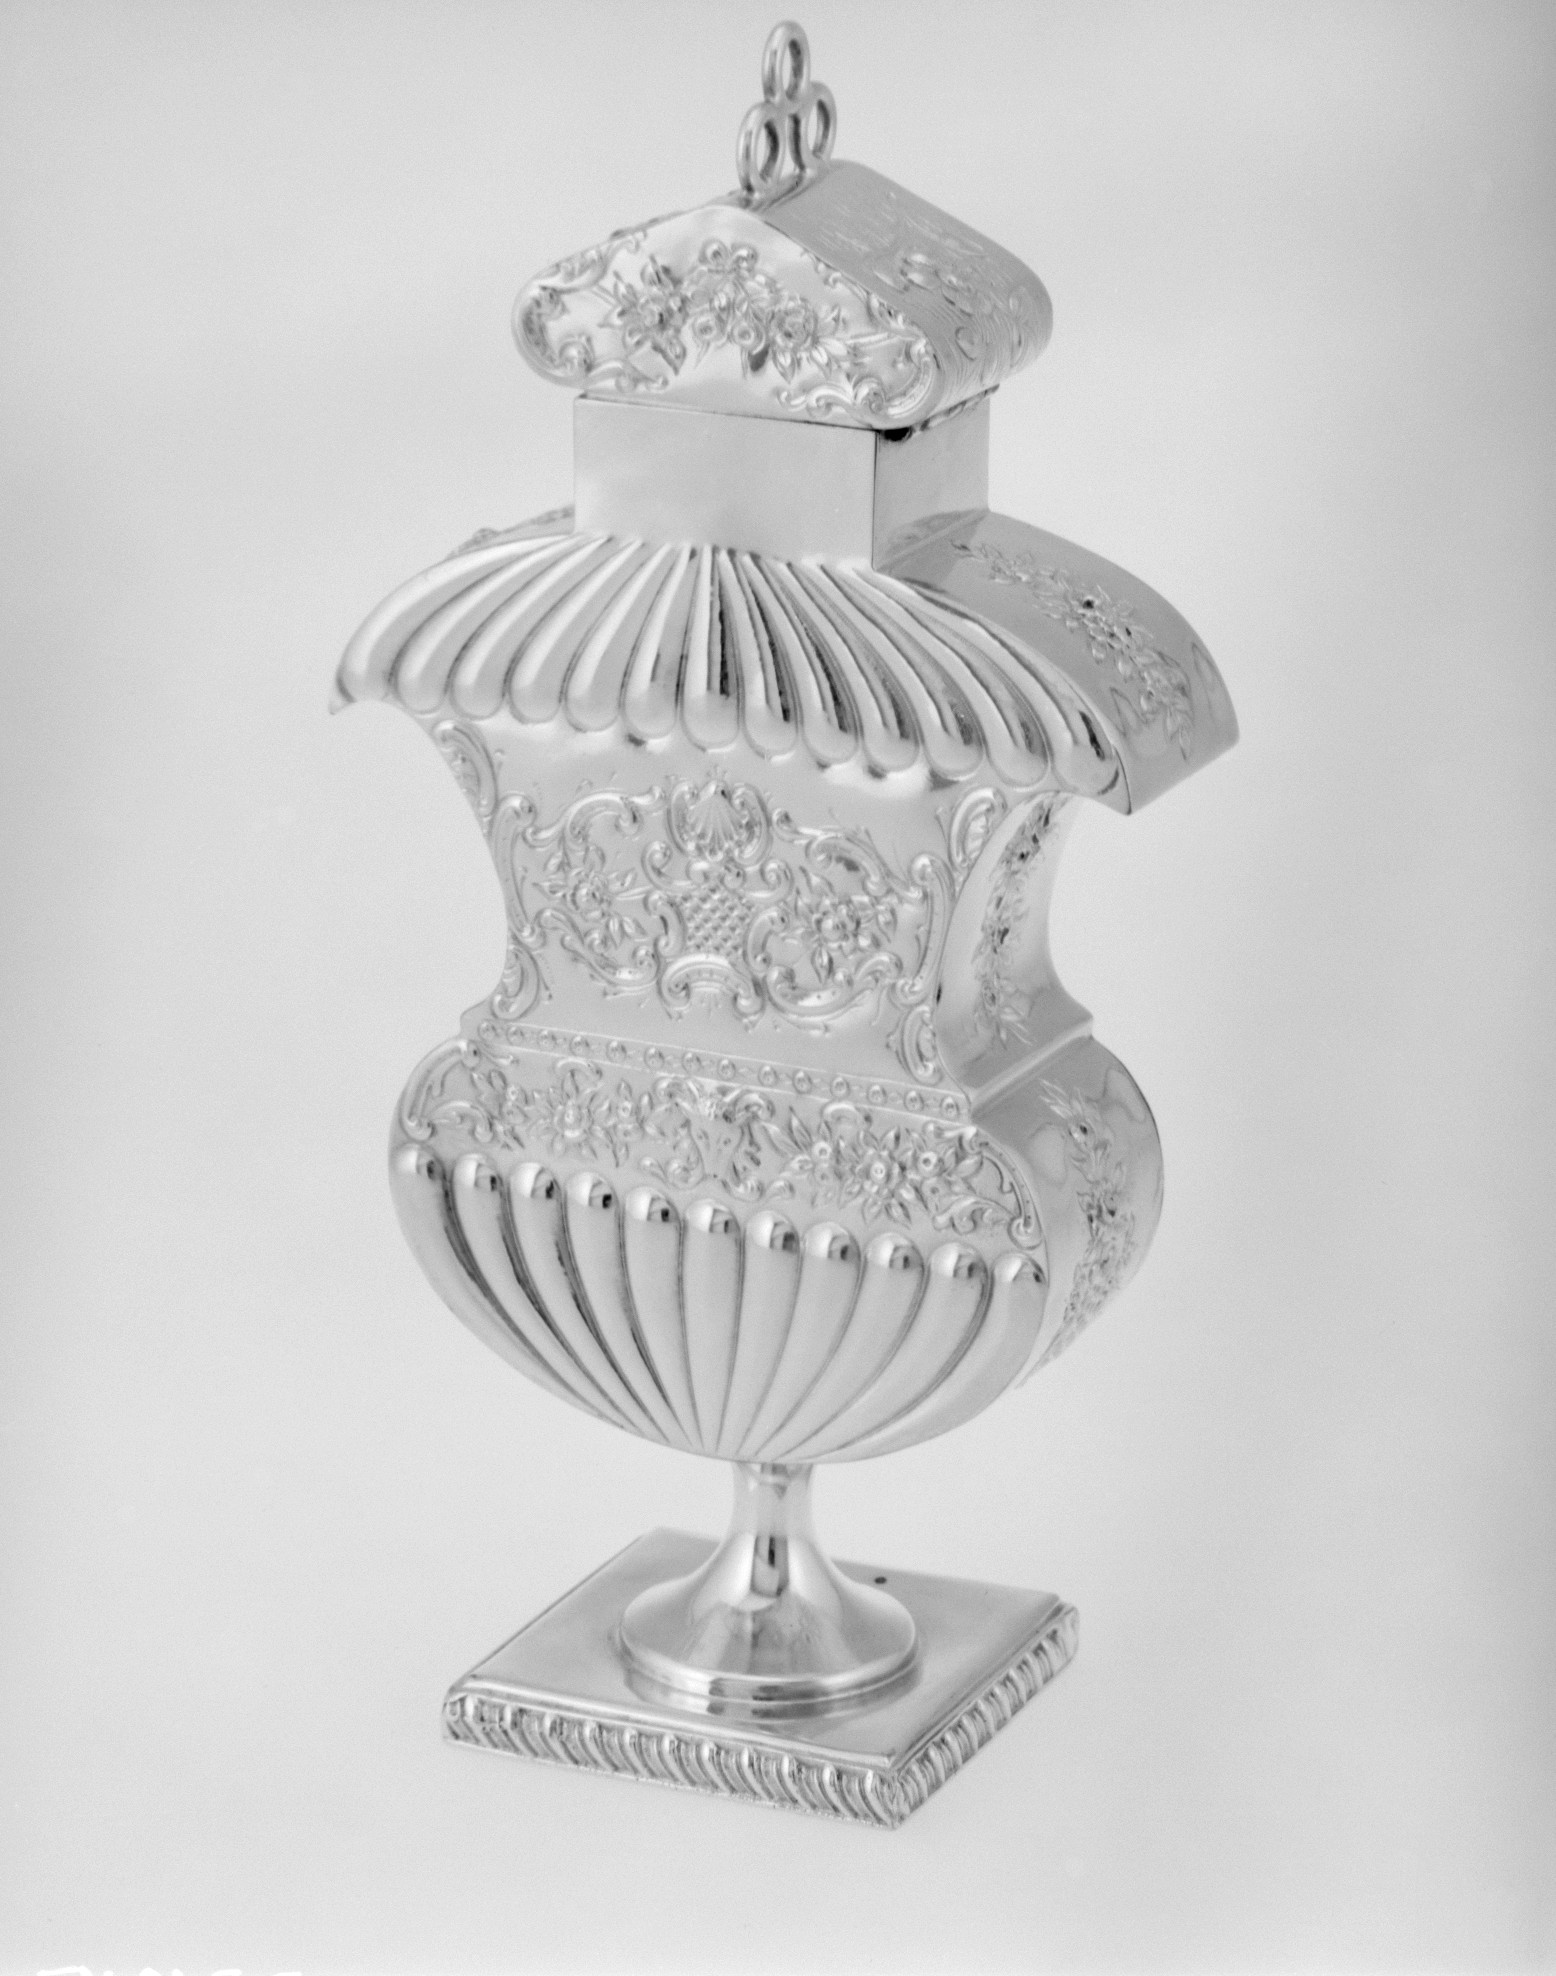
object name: tea caddy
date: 1840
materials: copper, silver